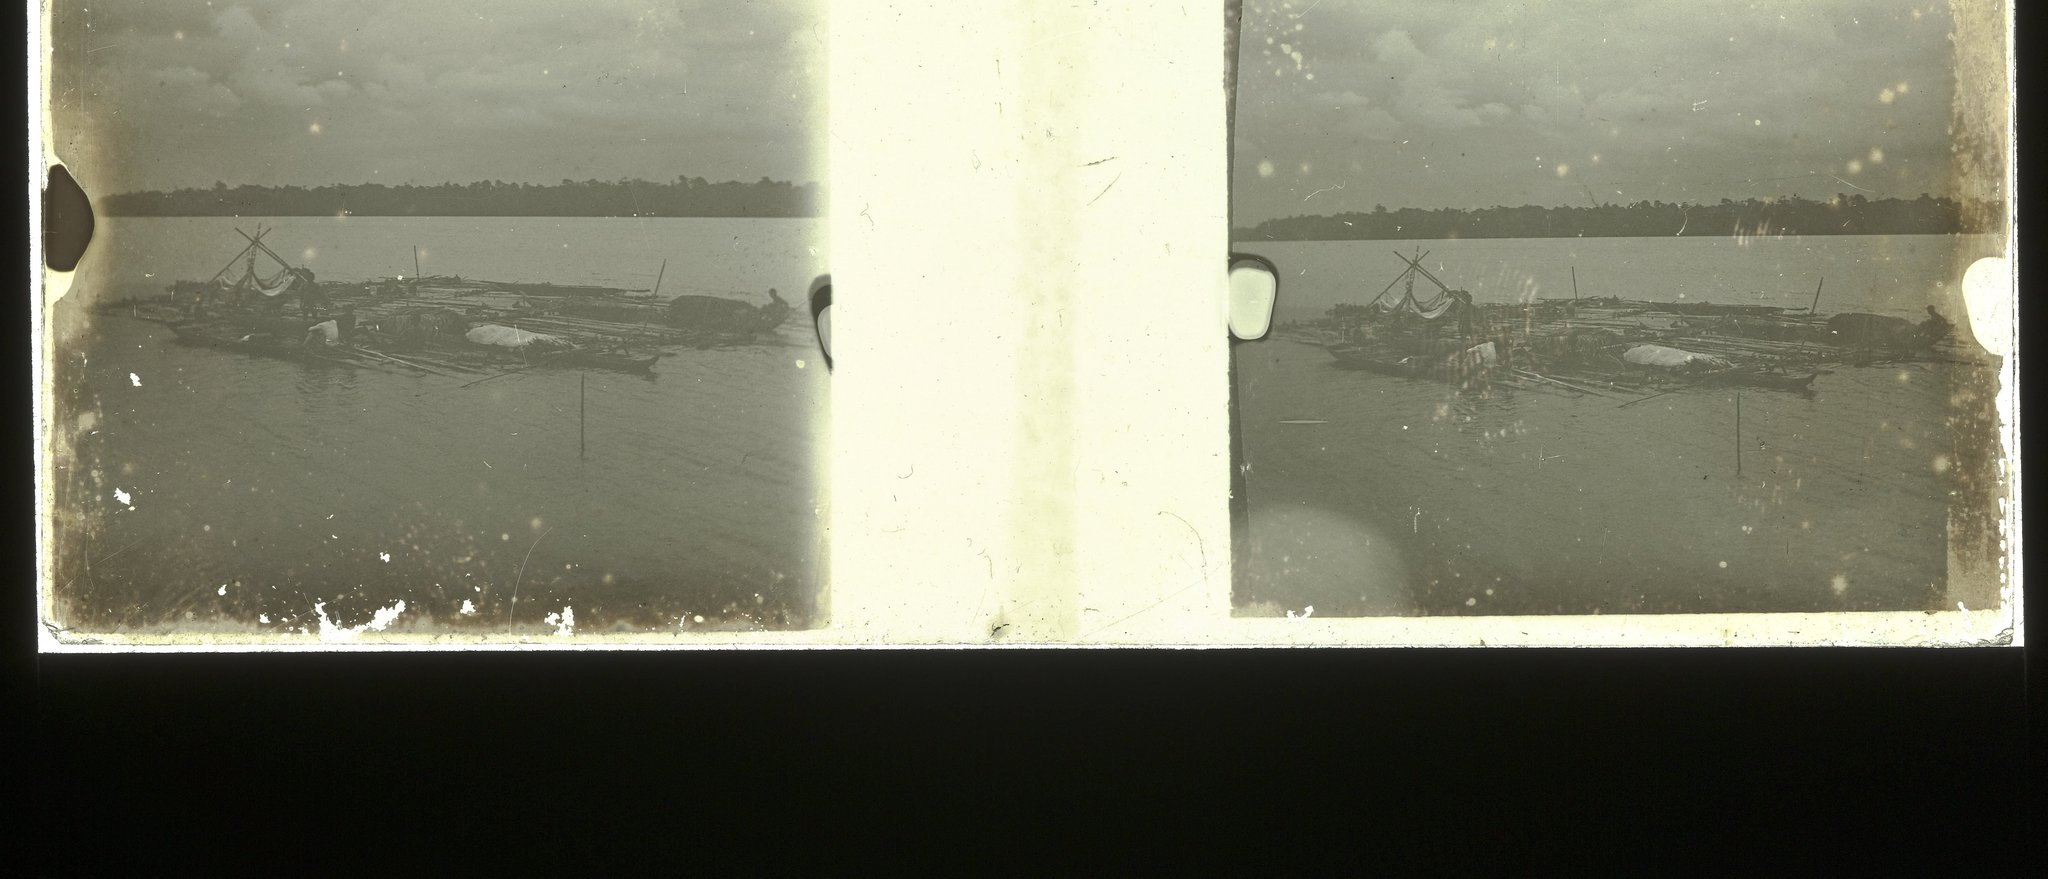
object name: stereograph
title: Houtvlot van Marrons op de Surinamerivier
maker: theodoor brouwers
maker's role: amateurfotograaf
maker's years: 1874-1932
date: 1913-1930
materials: glass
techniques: photography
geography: suriname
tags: theodoor brouwers, suriname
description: In de periode 1911-1932 woonde op plantage Accaribo in Suriname de familie Brouwers van wie de foto's afkomstig zijn. Rond 1910 vond Theodoor Brouwers werk op plantage Accaribo. In 1929 werd hij eigenaar van de plantage. Op Accaribo werden in zijn tijd bananen geproduceerd en wat koffie.